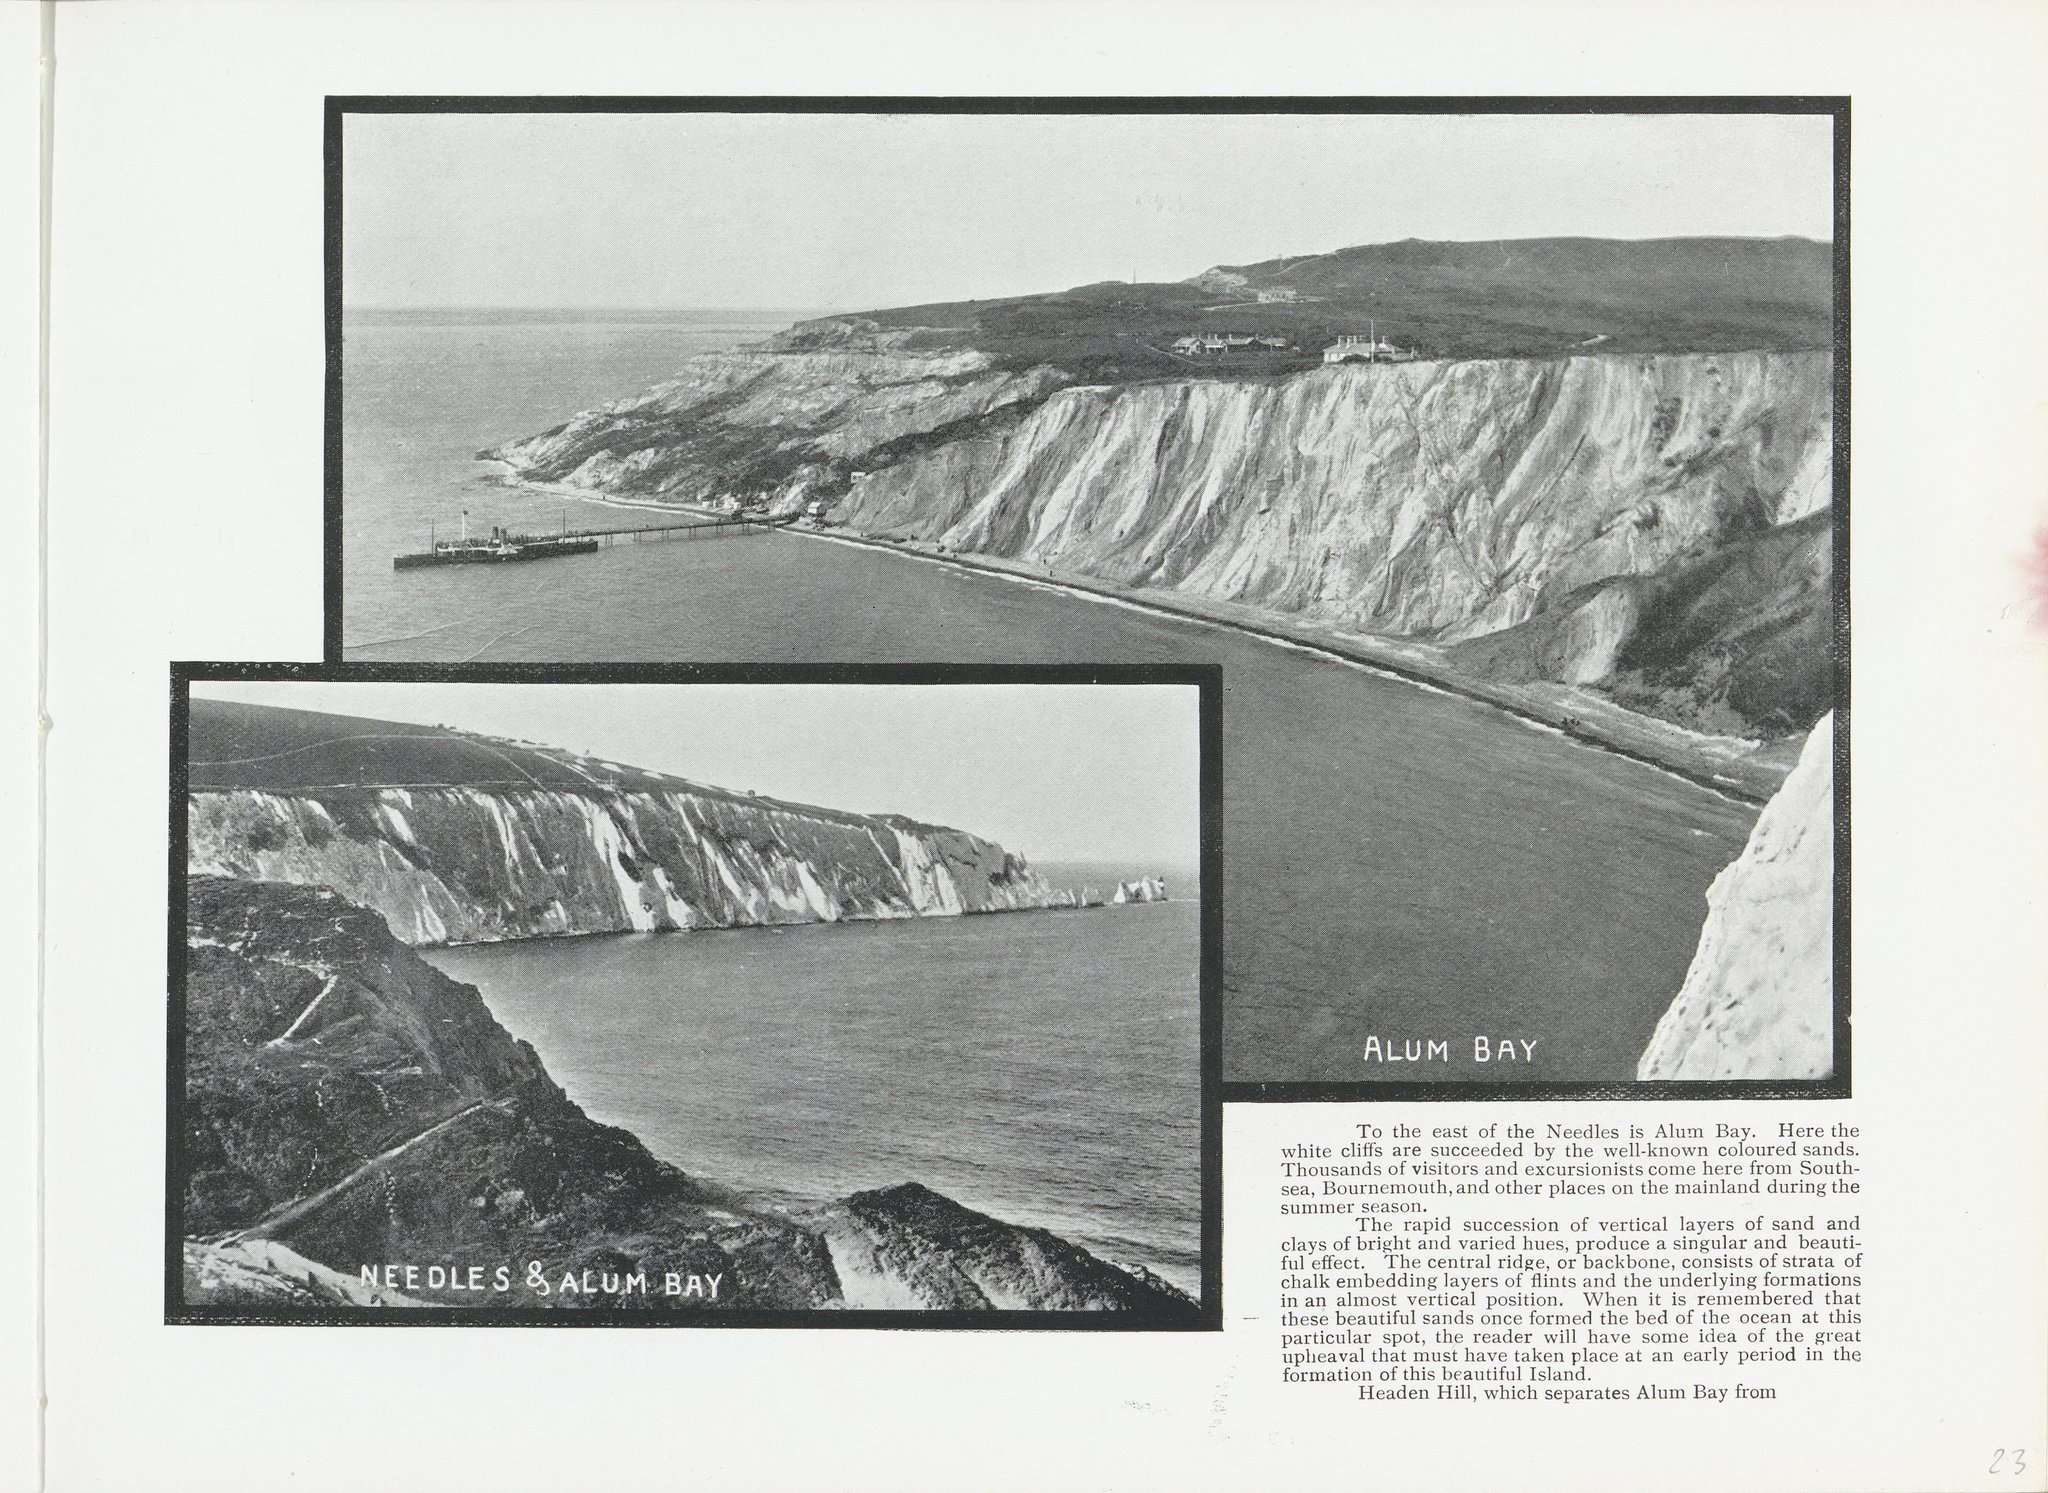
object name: page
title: Alum Bay en The Needles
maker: Anonymous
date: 1897-1930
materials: paper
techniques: printing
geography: isle of wight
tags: gulf, bay (+ landscape with figures, staffage), travelling; tourism, rock-formations, coastal cliff or crag, isle of wight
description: Pagina 23 met 2 foto's van Alum Bay en de The Needles en een bijschrift. Onderdeel van Fotografische reisreportage van het eiland Wight.